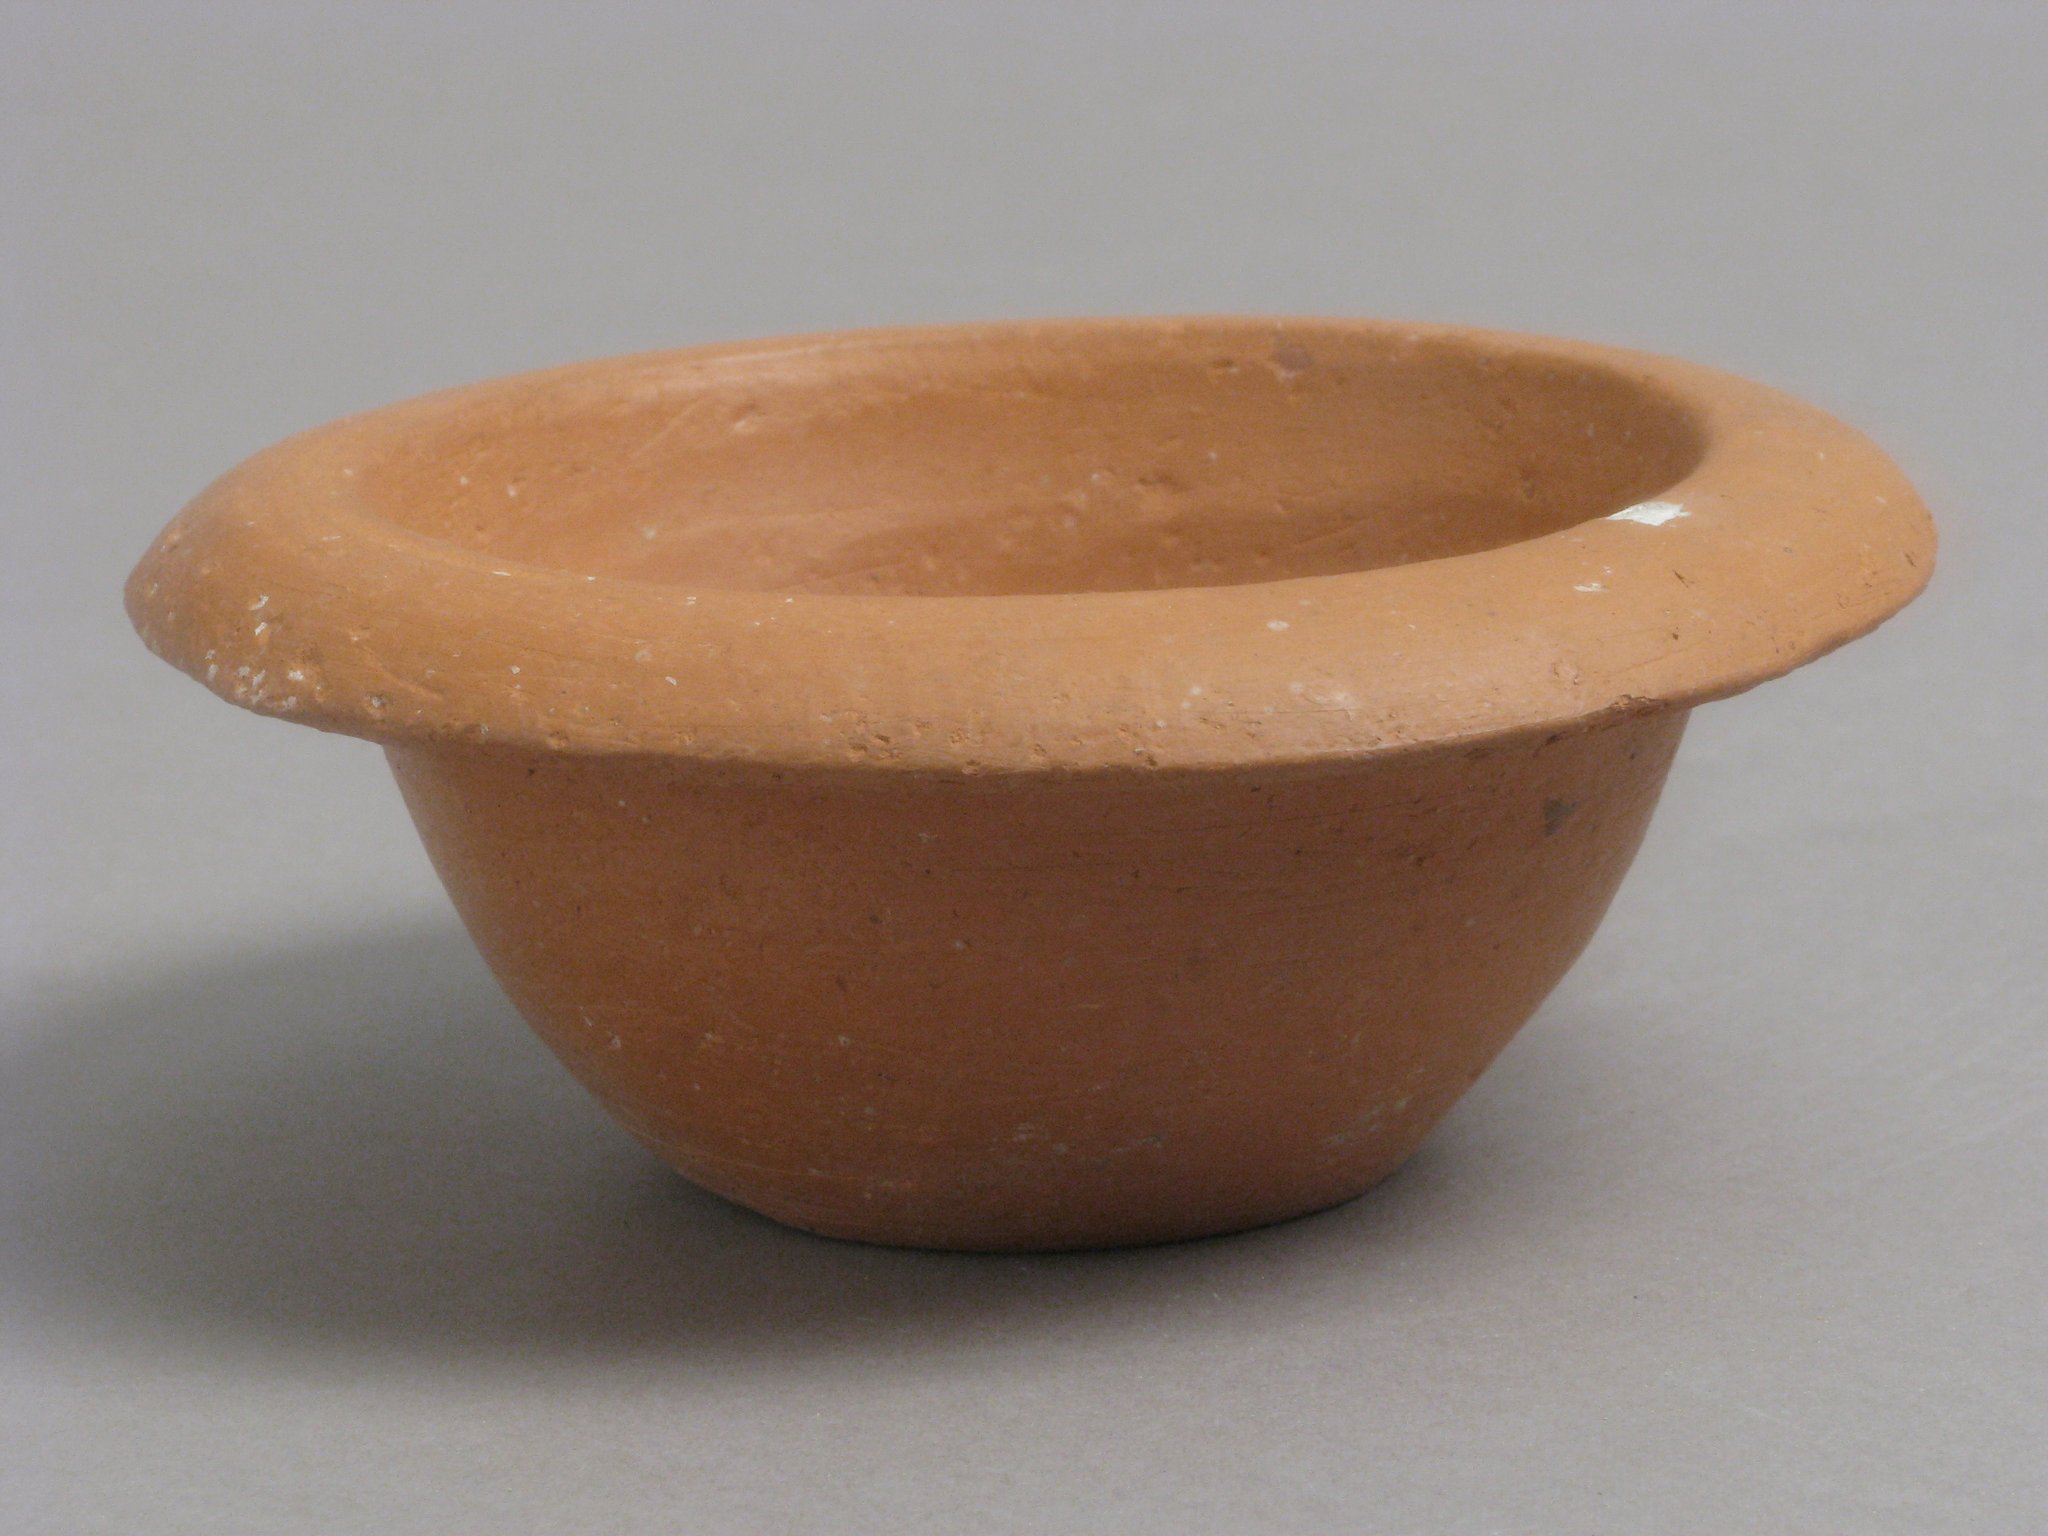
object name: bowl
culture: coptic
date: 301-700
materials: earthenware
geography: egypt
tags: bowls